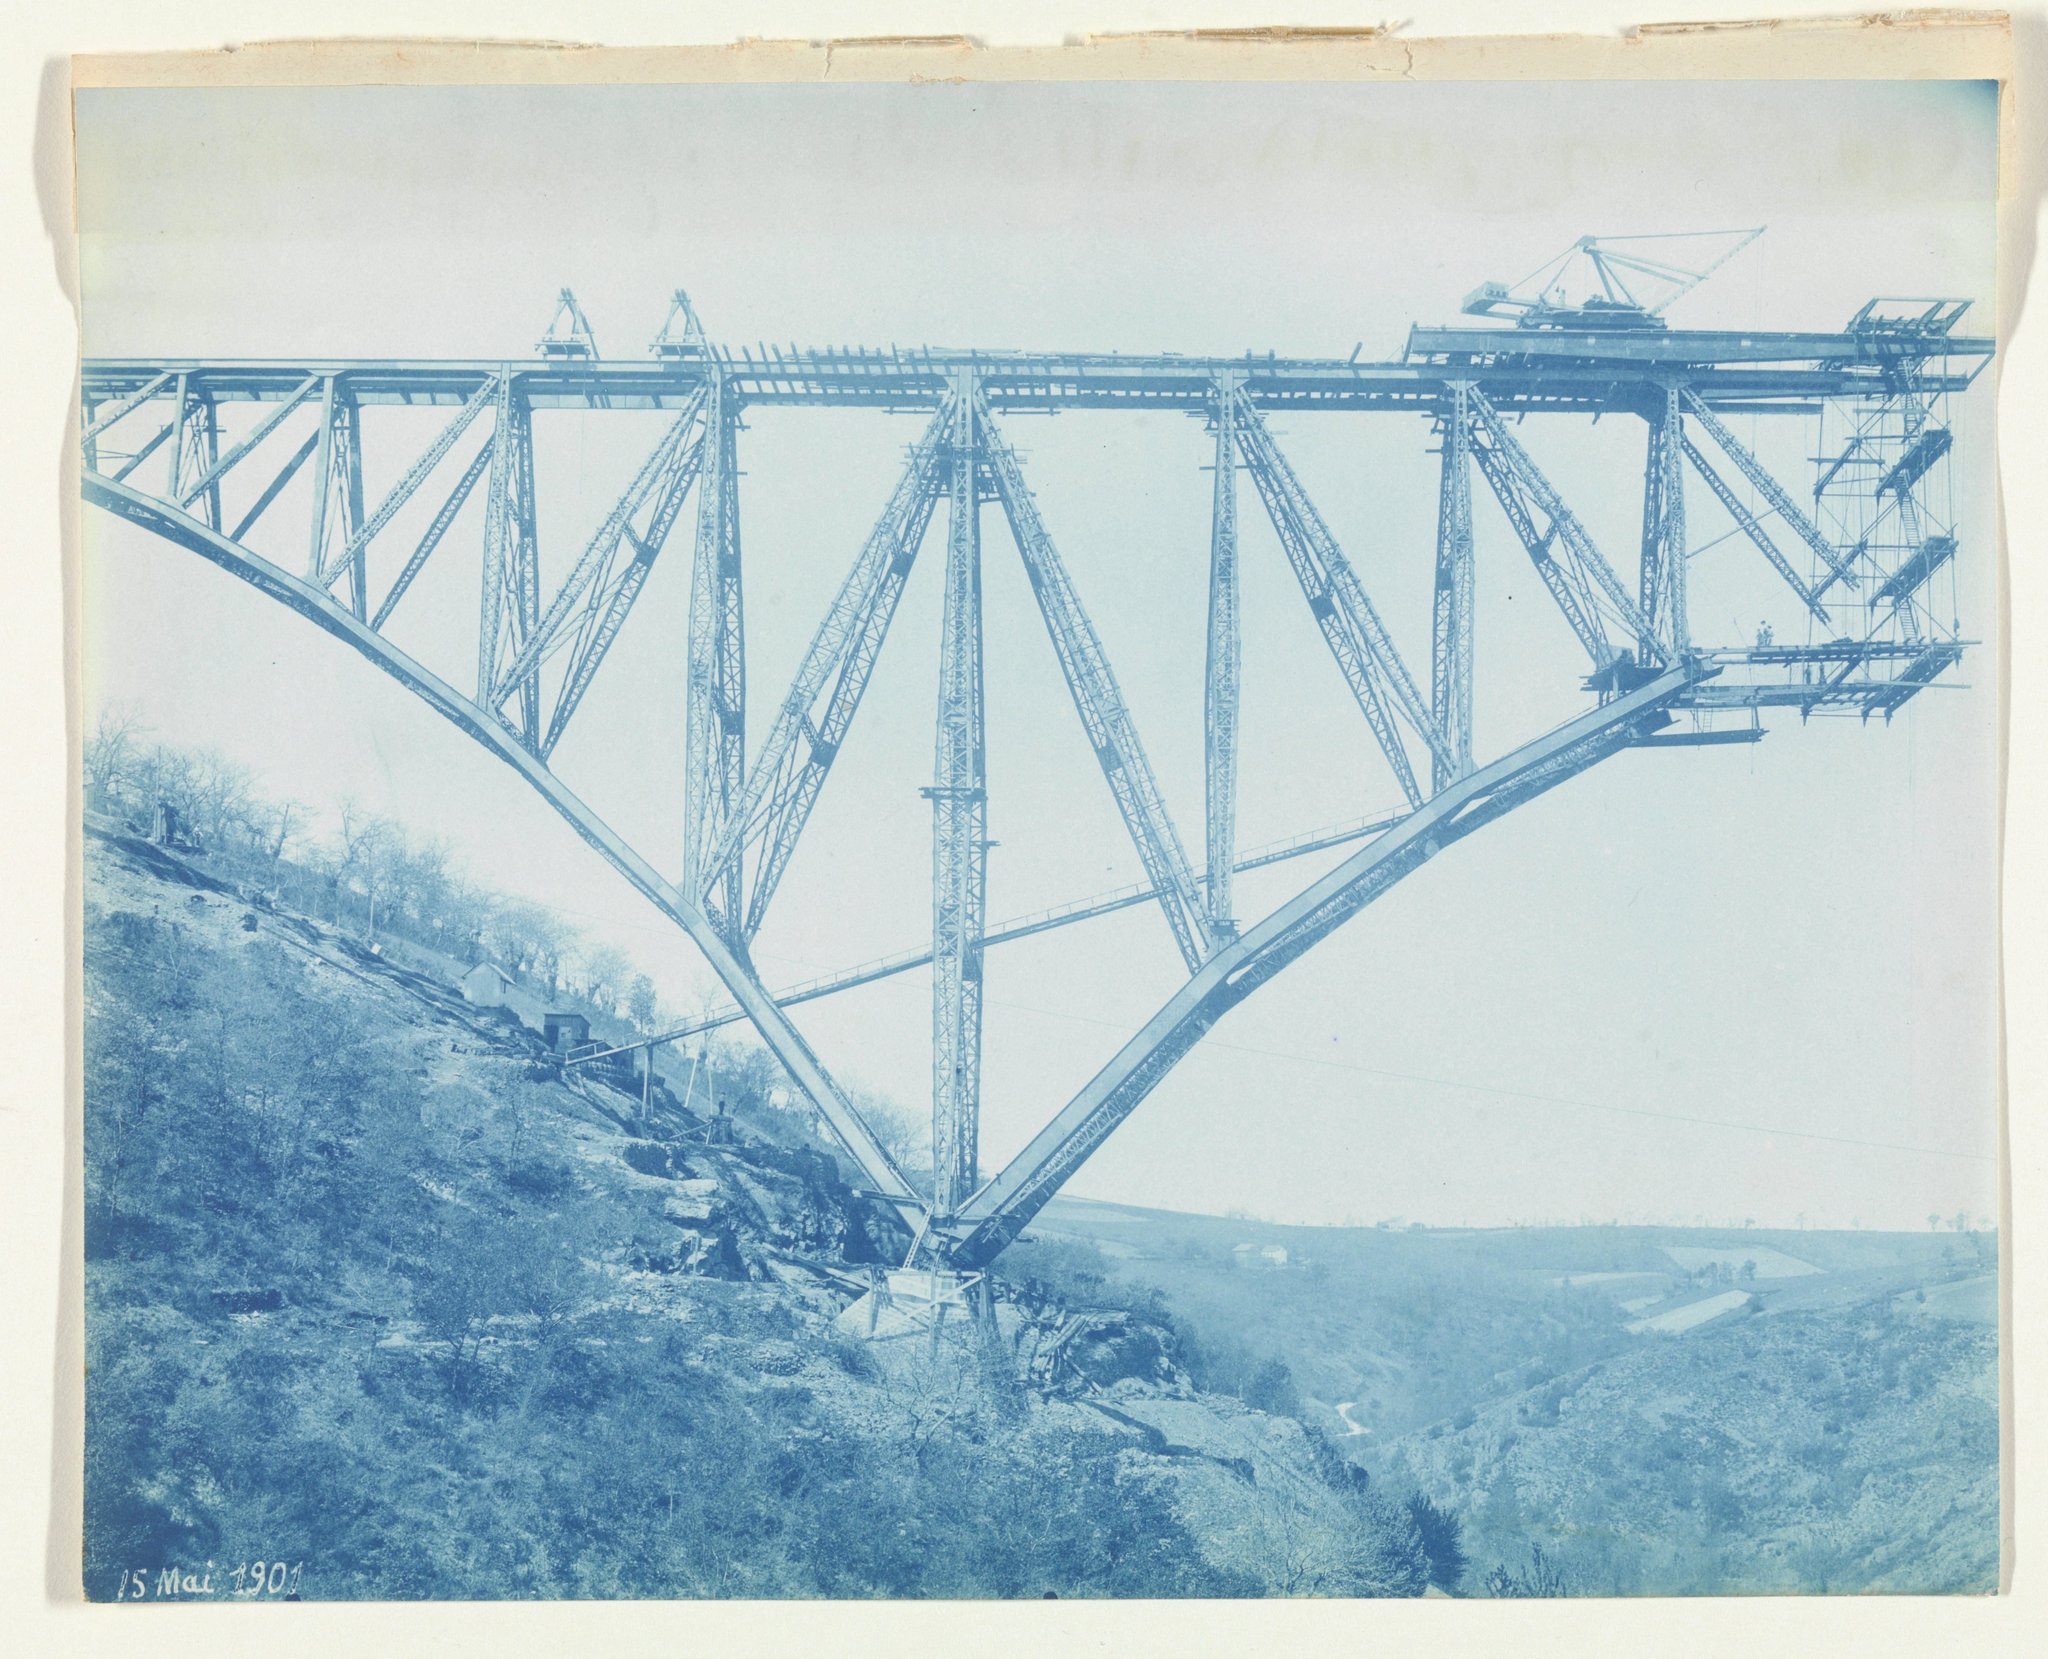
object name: photograph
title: Aanleg van het Viaur Viaduct in Frankrijk door de Societé de Construction des Battignolles, 15 mei 1901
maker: Anonymous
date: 1901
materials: photographic support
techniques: cyanotype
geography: france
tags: viaduct, making the overground structures (~ building activities)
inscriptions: date